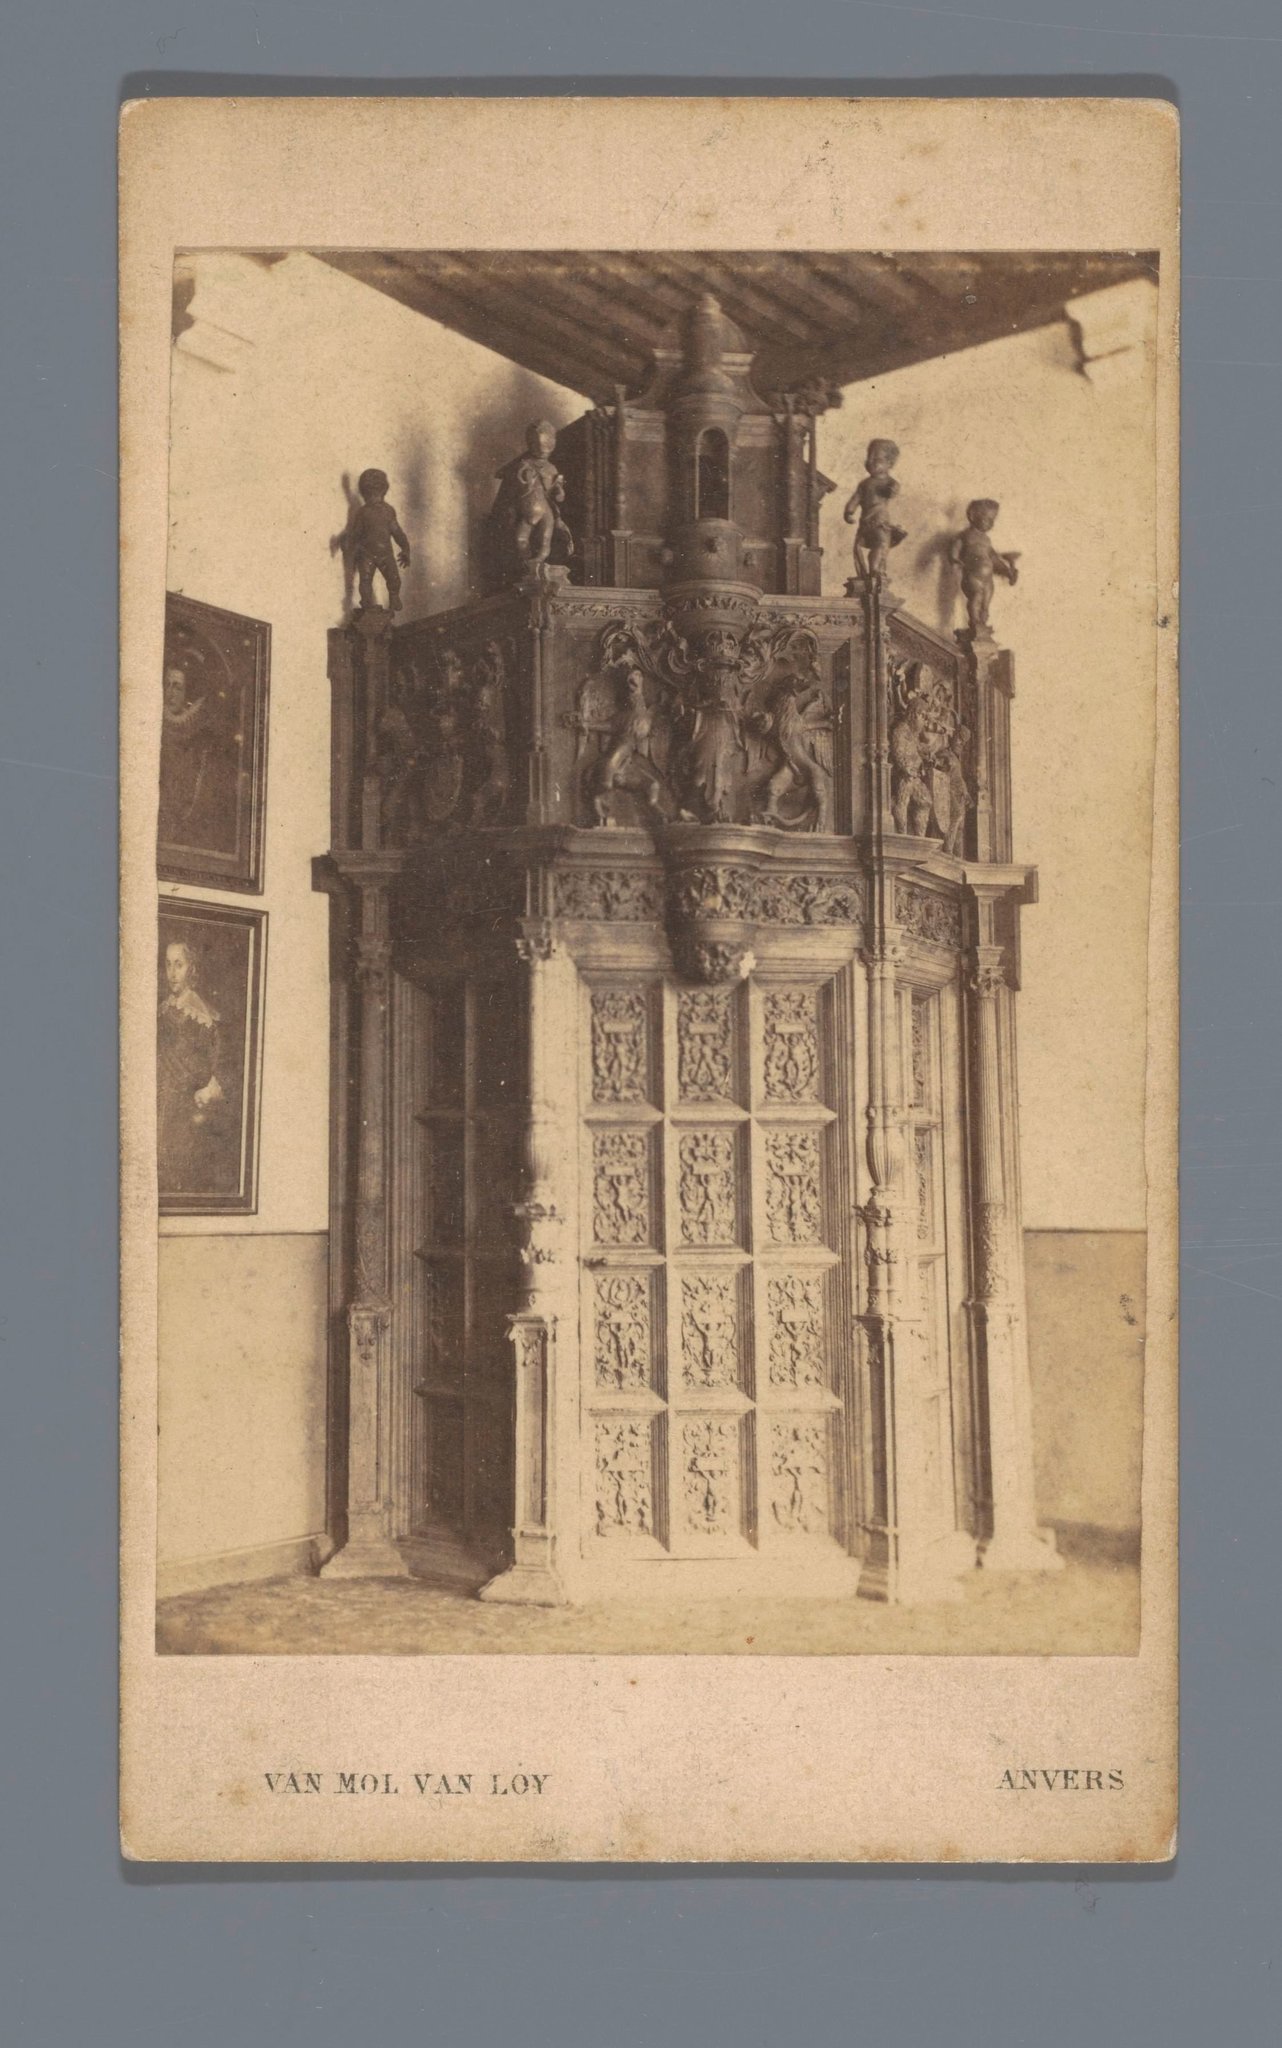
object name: photograph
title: Biechtstoel te Antwerpen, België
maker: van mol van loy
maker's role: fotograaf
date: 1851-1880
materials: cardboard, paper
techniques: albumen print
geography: antwerp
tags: carving ~ applied arts, confessional ~ part of the confession, antwerp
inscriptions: inscription: ‘J. B. VAN MOL VAN LOY/ LIBRAIRE/ 29, MARCHÉ AUX OULIERS, 29/ ANVERS’